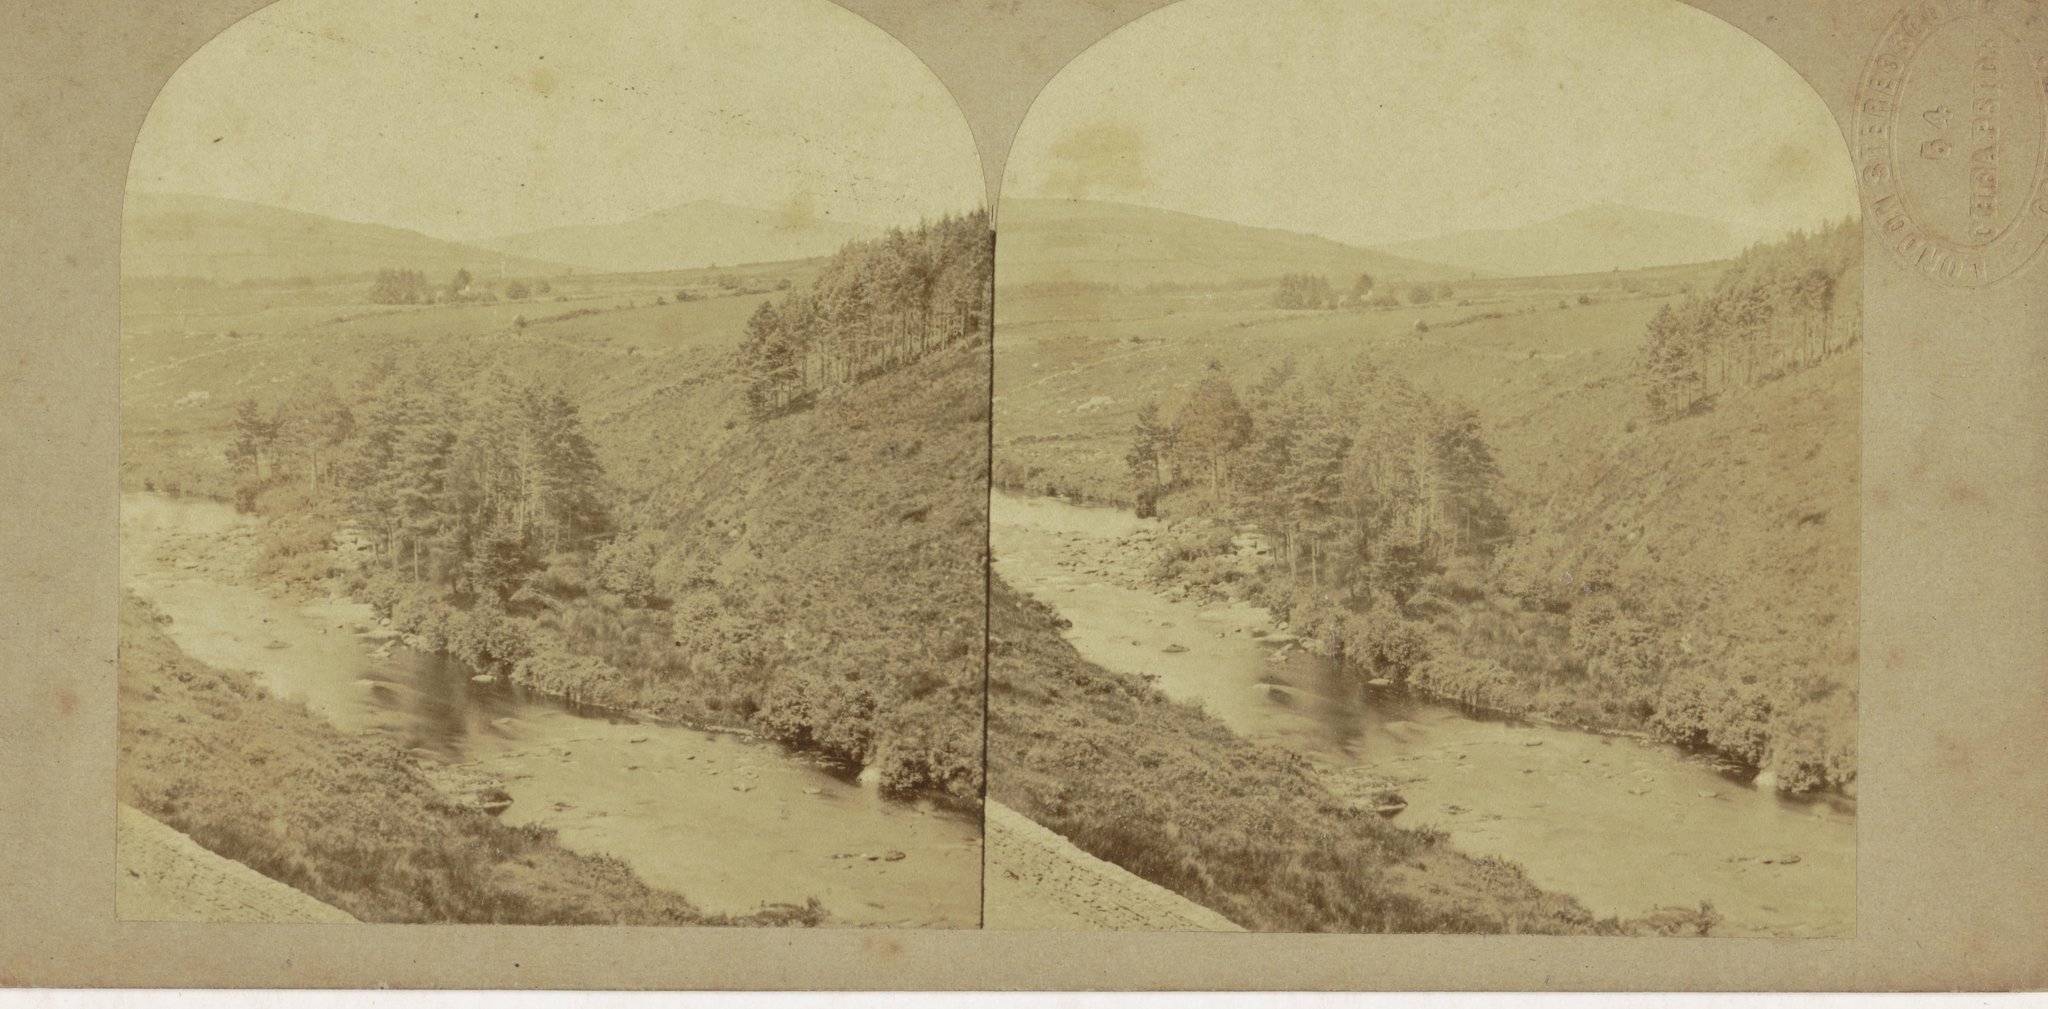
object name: stereograph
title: Vallei van Angram, Graafschap Wicklow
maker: Anonymous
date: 1856-1922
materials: cardboard, paper, photographic support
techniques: albumen print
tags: ierland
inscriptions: inscription: ‘N.° 12.’, label: ‘47 - View in the Valley of Angram, County Wicklow.’, name: ‘H. Ameschot.’, check stamp: ‘London Stereoscopic Company / 54 Cheapside’